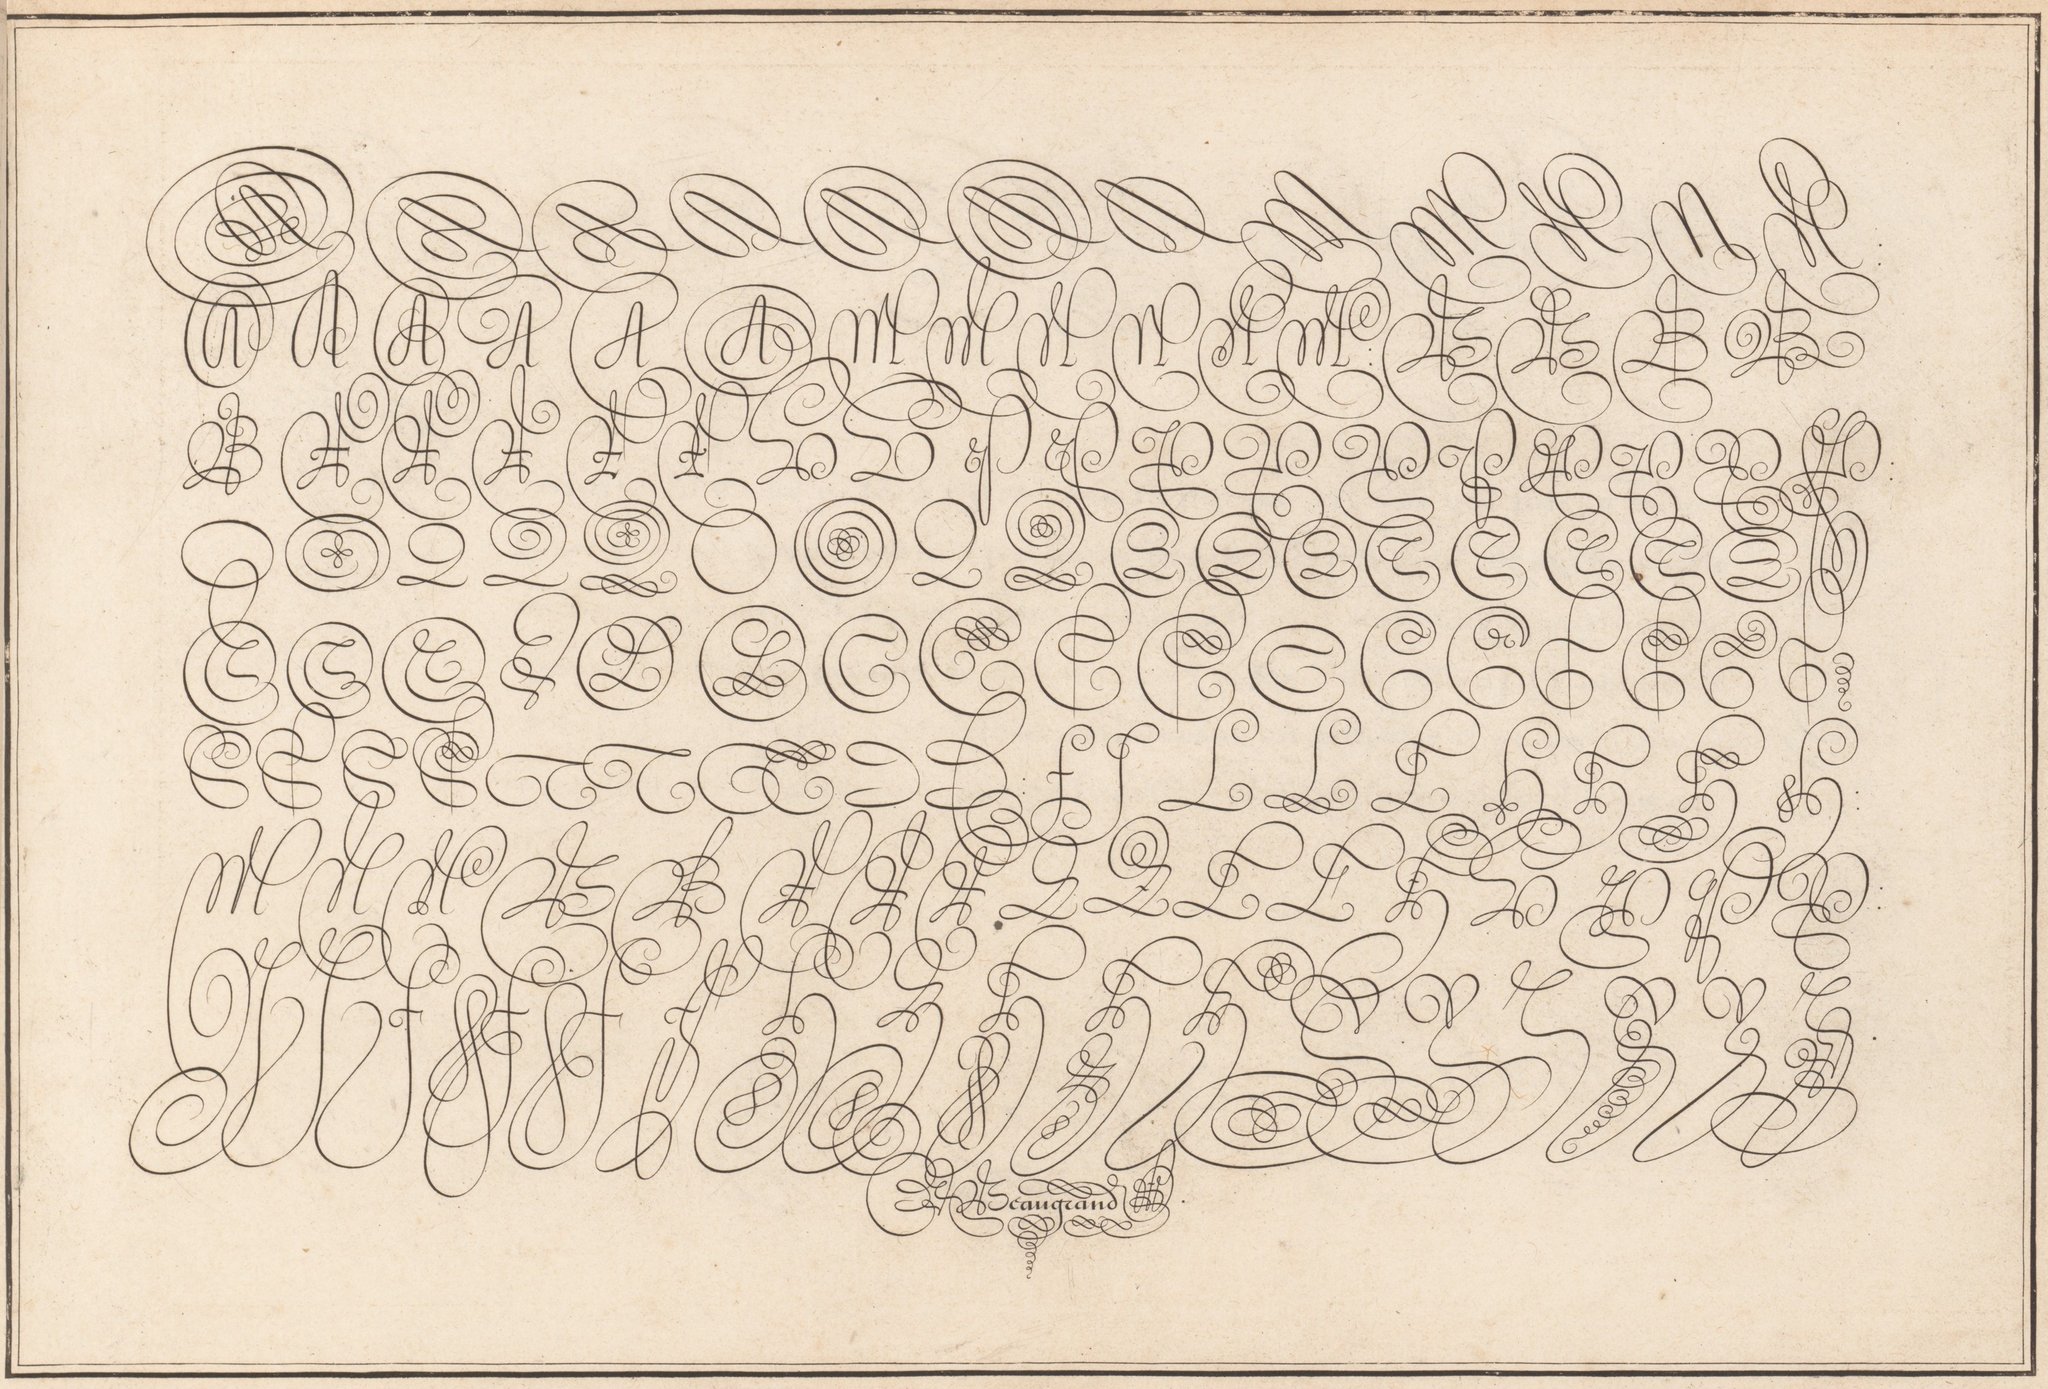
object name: book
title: Panchrestographie & Poecilographie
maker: jean de beaugrand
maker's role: artist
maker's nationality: french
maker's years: 1600-1700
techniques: engraving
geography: france